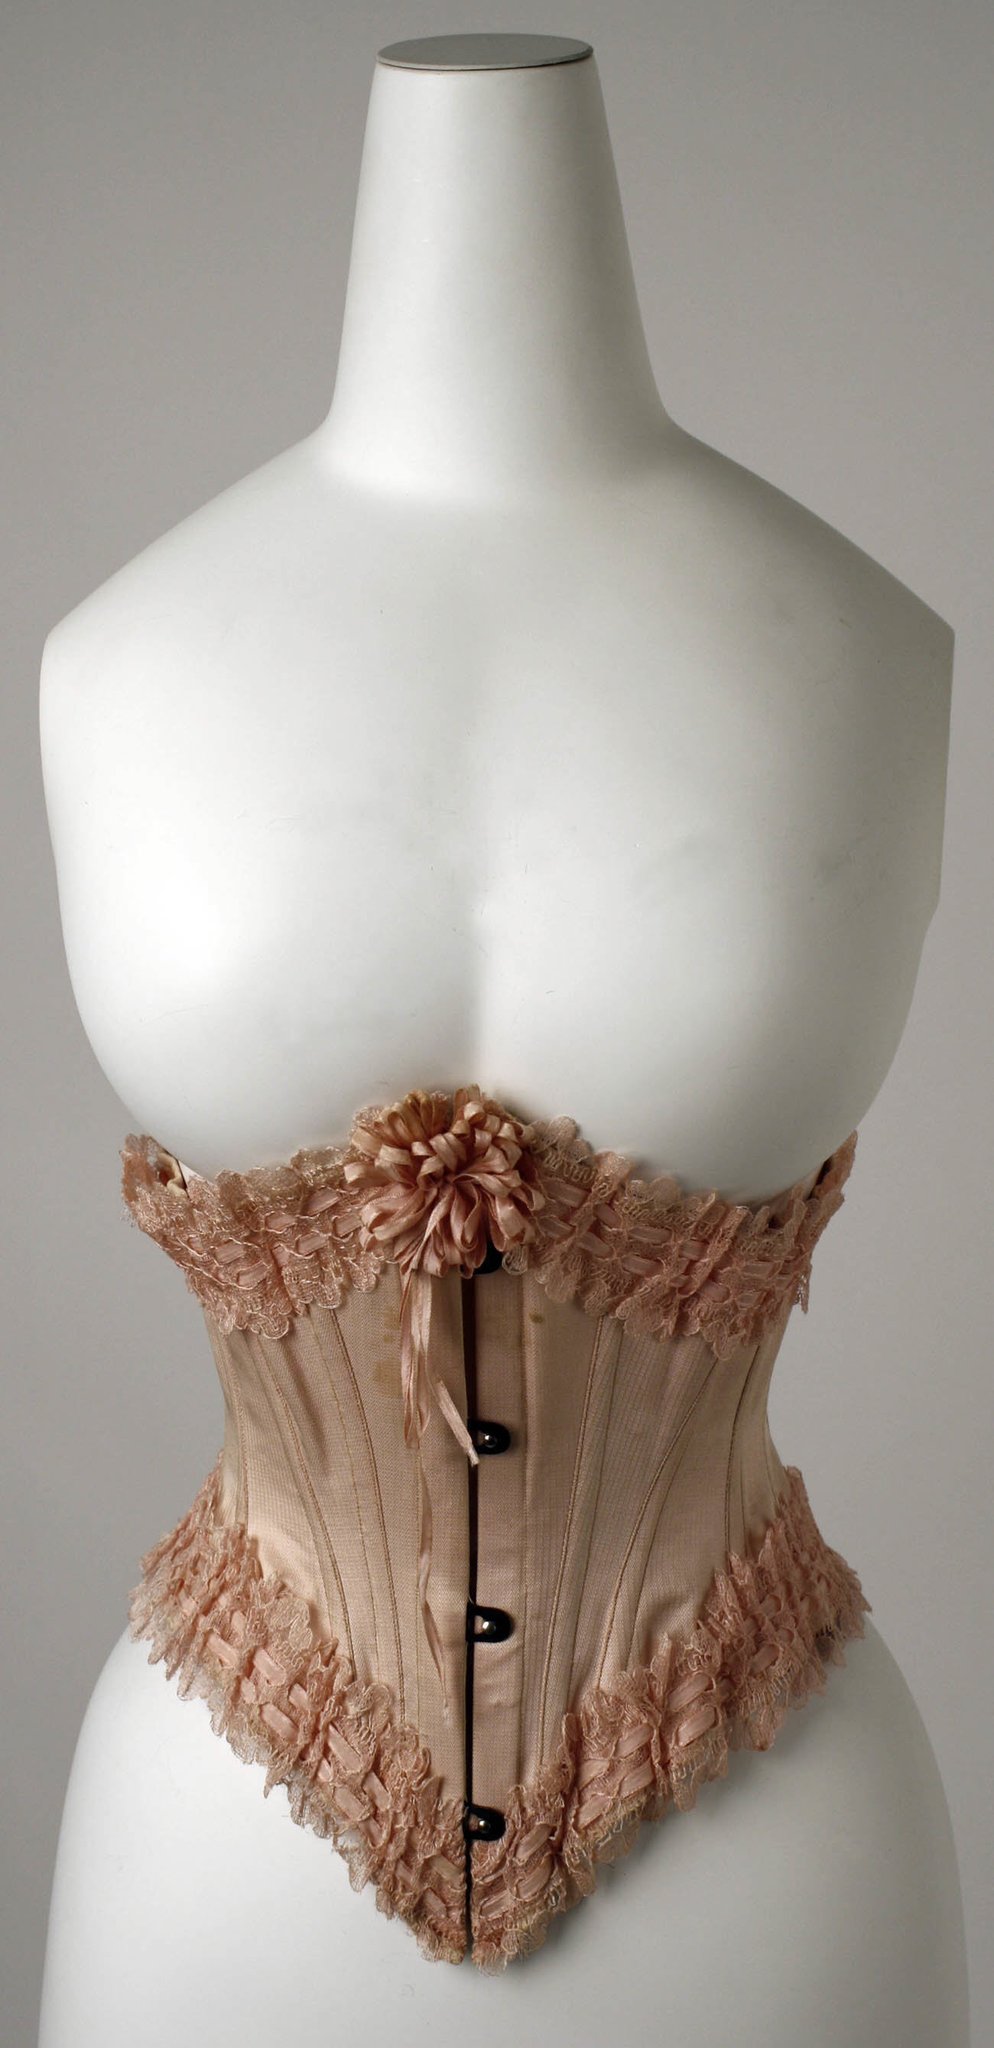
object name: corset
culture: american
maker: stern brothers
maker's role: department store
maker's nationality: american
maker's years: 1867-2001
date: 1900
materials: cotton